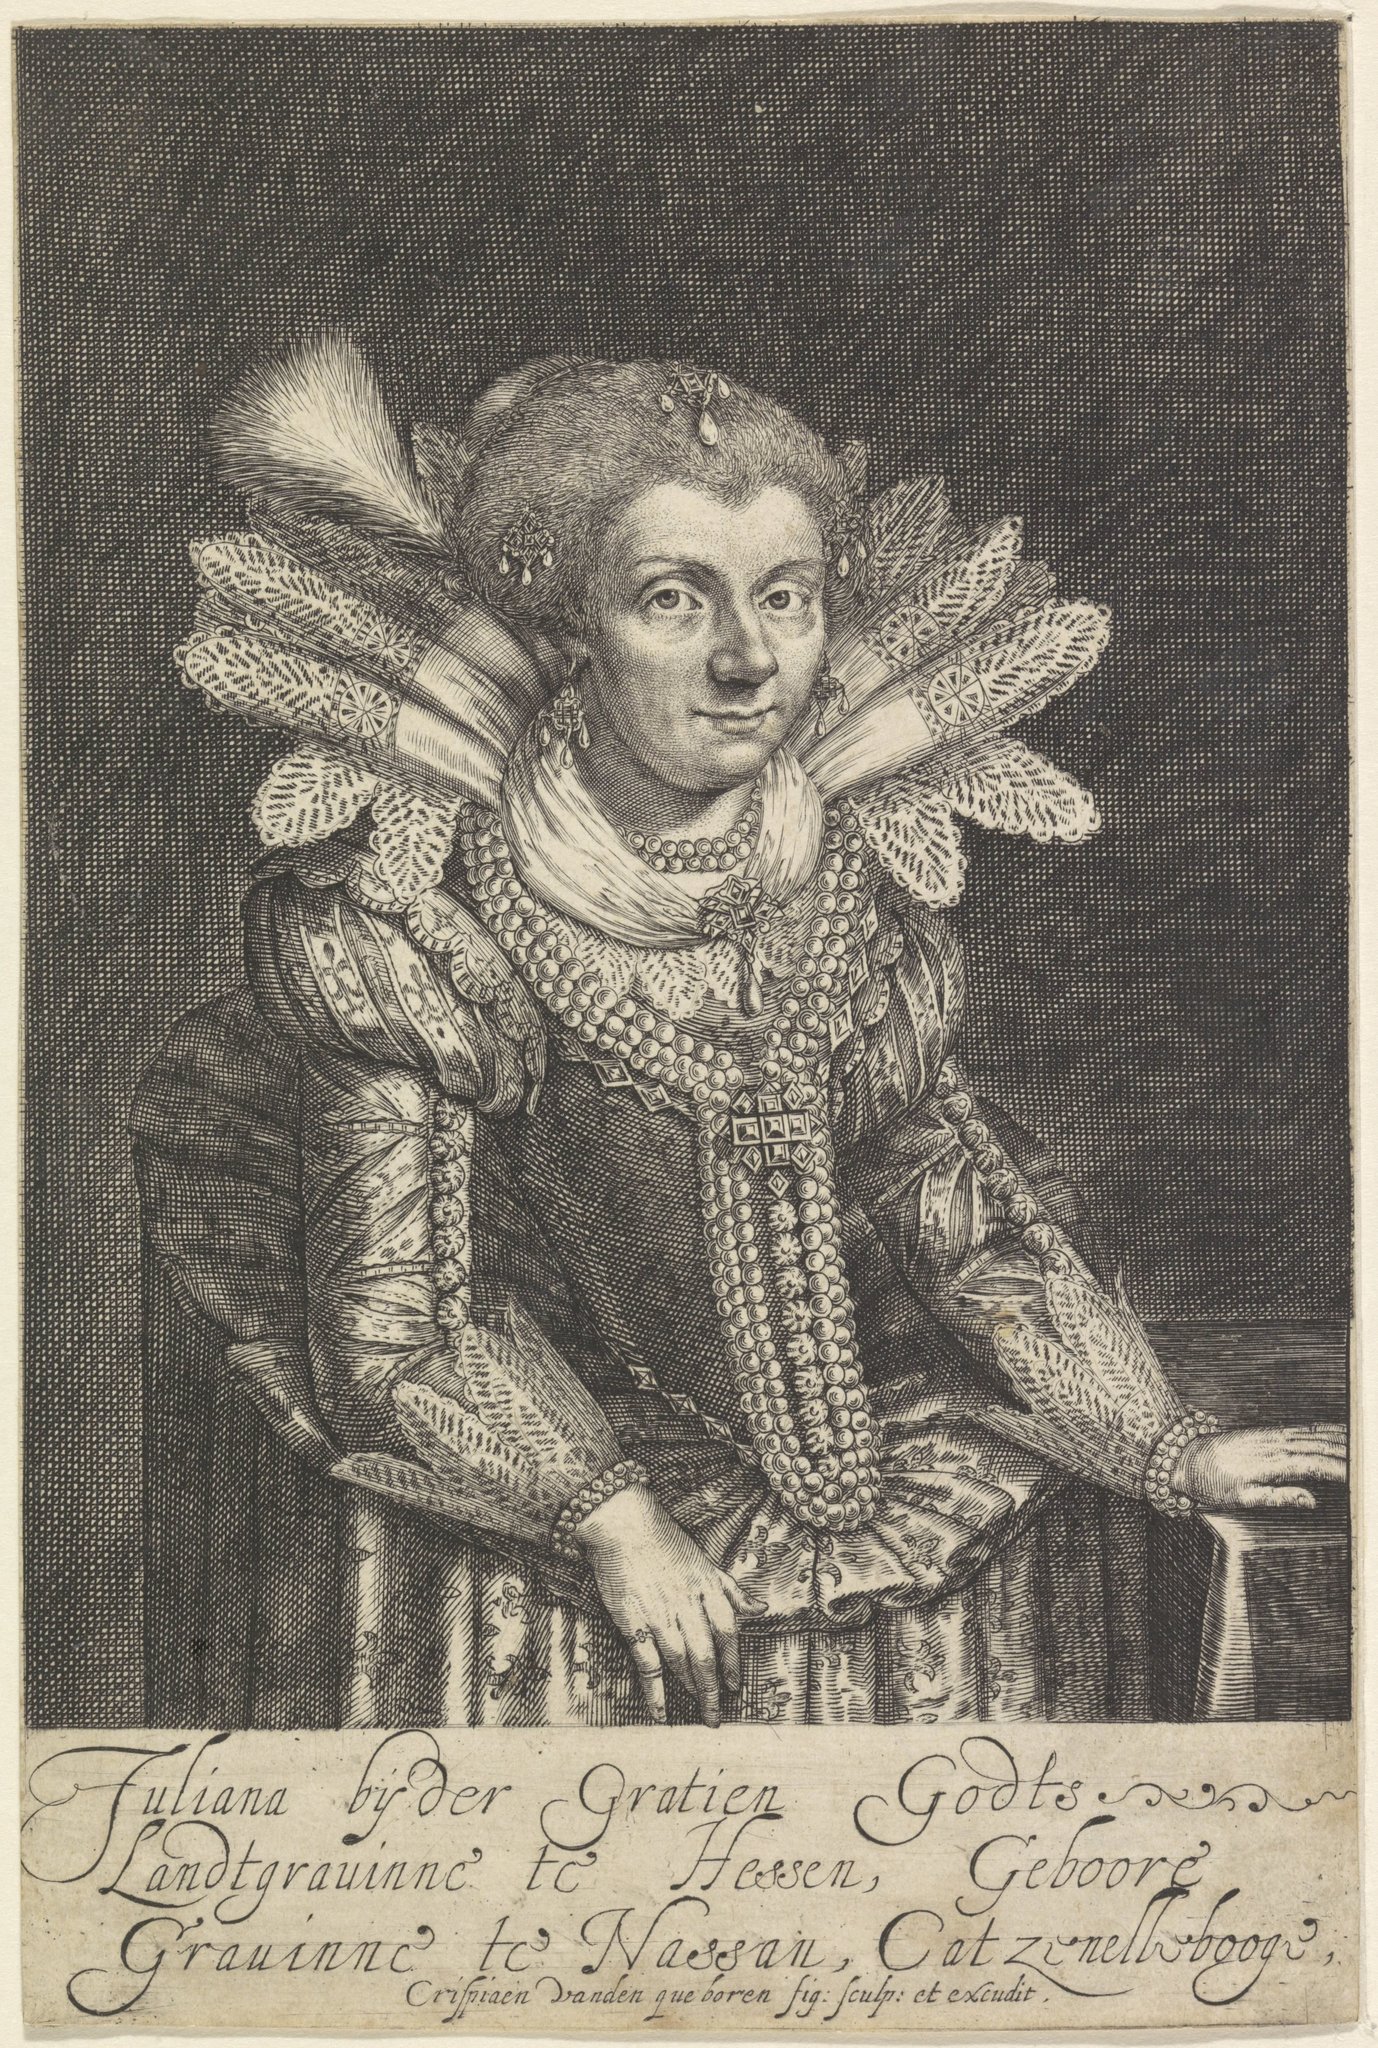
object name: print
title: Portret van Juliana, gravin van Nassau-Siegen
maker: crispijn van den queborn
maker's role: print maker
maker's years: 1595-1652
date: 1625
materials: paper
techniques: engraving, etching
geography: the hague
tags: juliana gravin van nassau-siegen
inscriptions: collector's mark: Lugt 963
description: De hier vermelde titel verwijst naar de hoogst verkregen titel van de geportretteerde, niet per se naar de titel die de geportretteerde op deze voorstelling draagt.